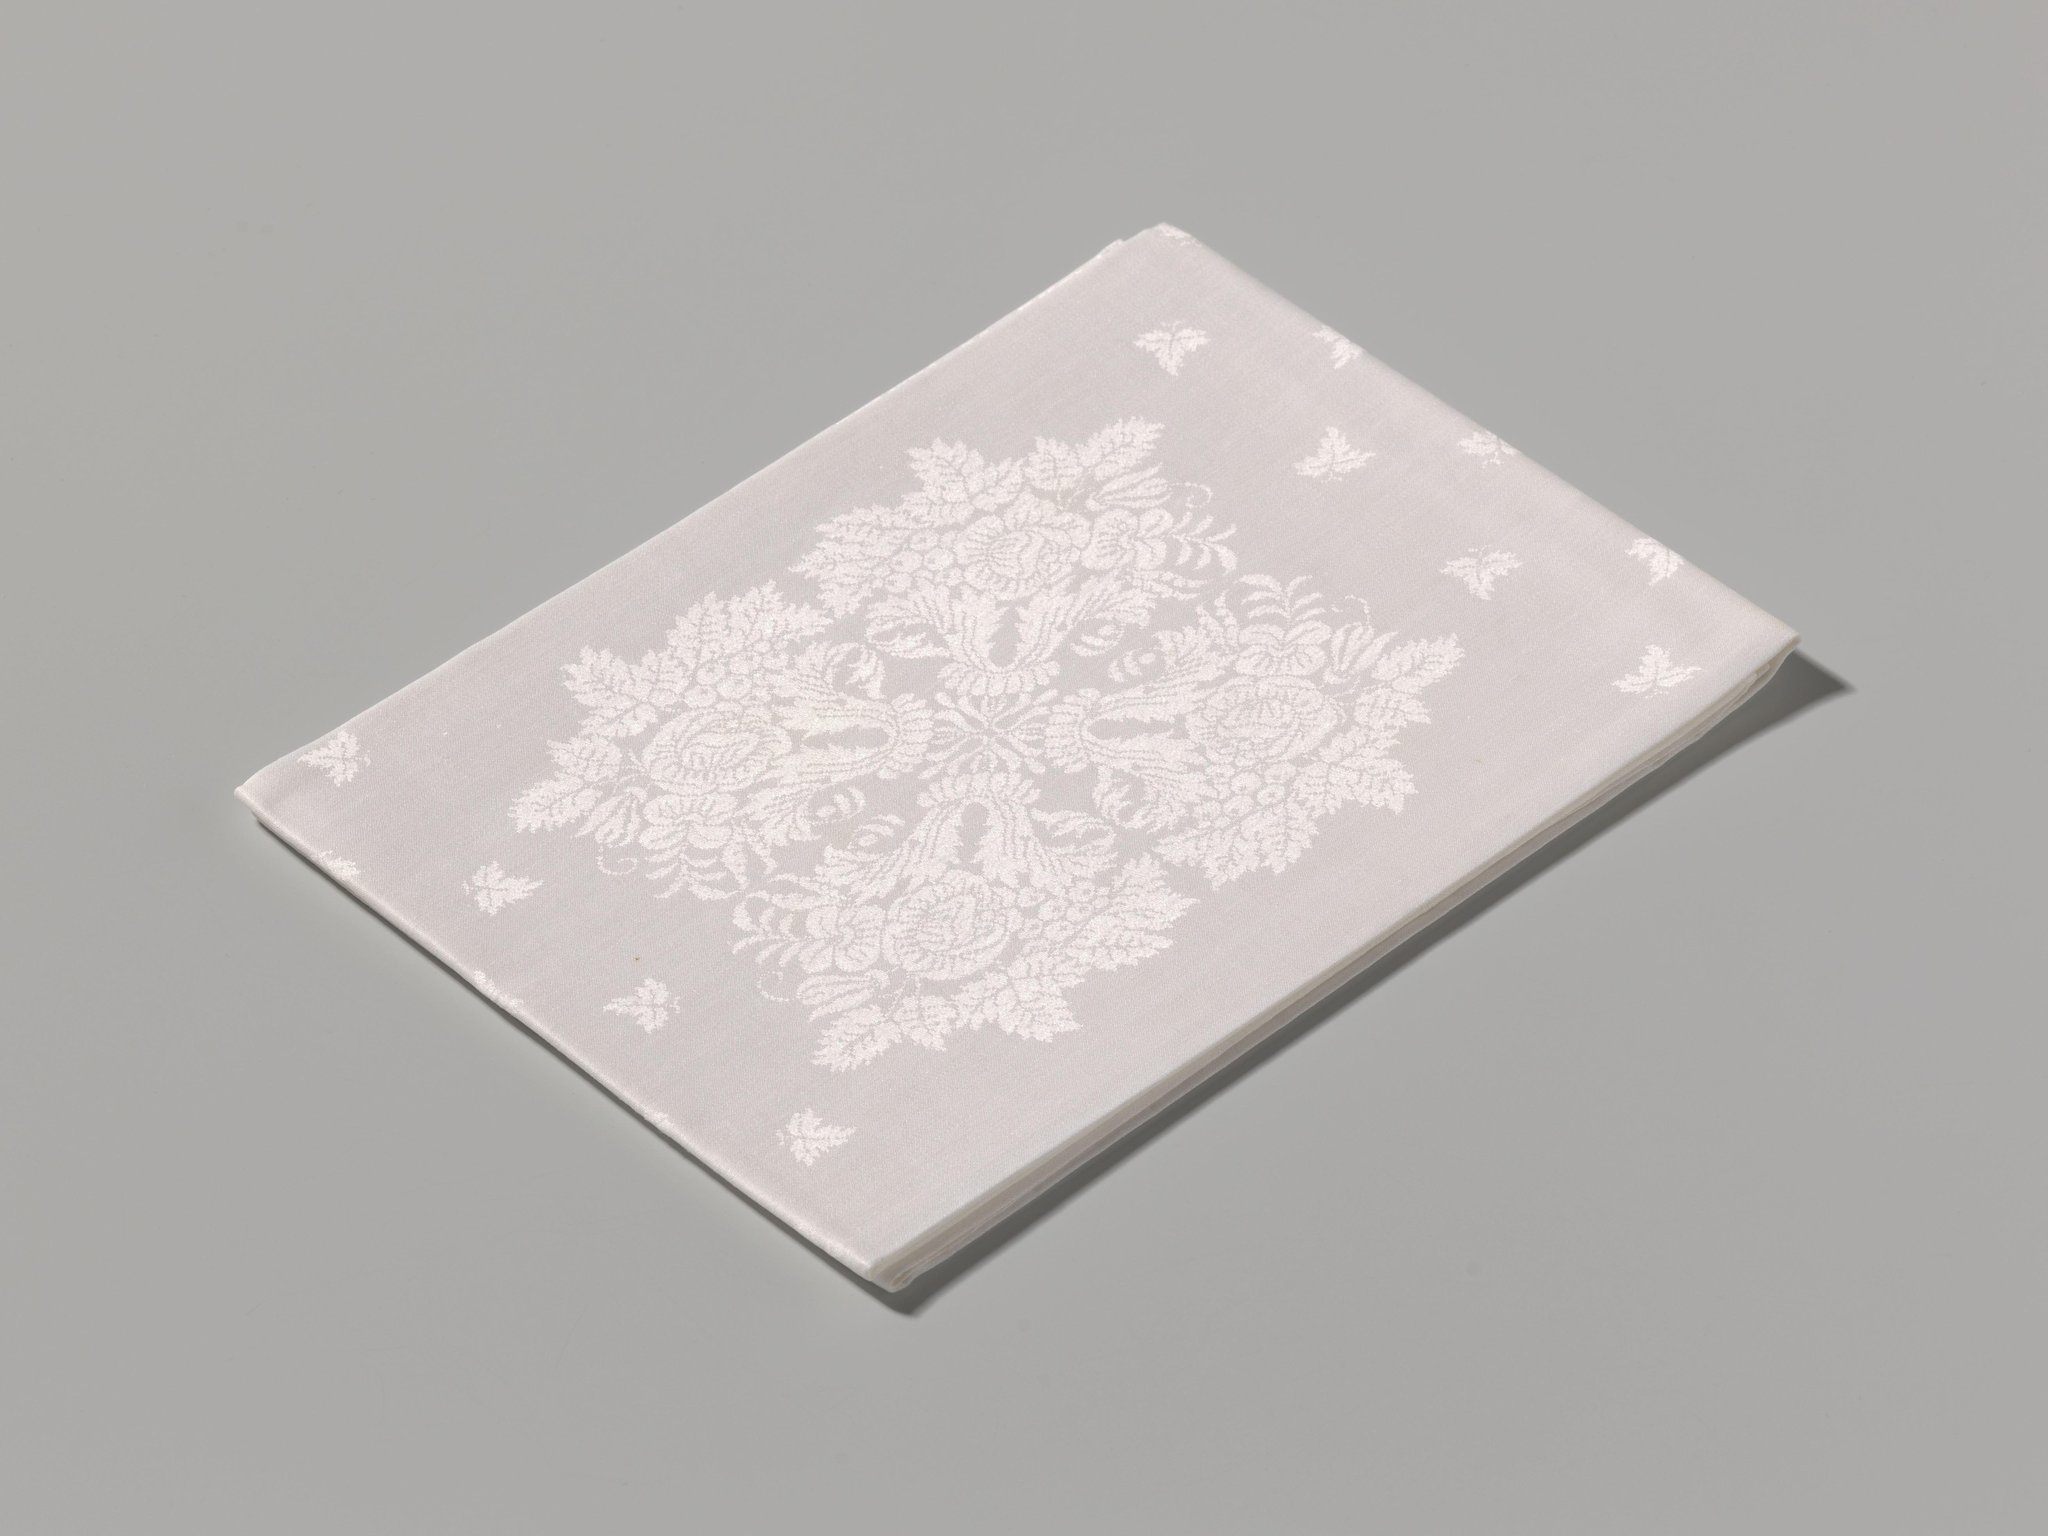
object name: napkin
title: Servet met herme, god en leeuwen te midden van acanthusbladeren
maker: Anonymous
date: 1850-1899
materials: linen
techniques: damask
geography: north brabant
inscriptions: mark: ‘GH 18’, label: ‘R.M. A'dam’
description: Servet van linnendamast met herme, god, leeuwen te midden van acanthusbladeren. Middenveld: Vierpassen van bloemboeketten met roos en gestrooid bladwerk. In de niet omgrensde vierpassen staan de telkens op twee acanthusvoluten geplaatste boeketten overhoeks. Hoeken: overhoeks geplaatst een herme met Midas-kop (of ezelskop?), met muziekinstrumenten en thyrsusstaven. Links en rechts een toegewende leeuw, in toom gehouden door een gevleugelde jonge God (Apollo?) in draperie gehuld. Randen: zonder scheidingslijn is het veld omgeven door een brede rand van symmetrische acanthusranken. Beurtelings dragen de diep ingesneden, gevederde bladvoluten een vruchten- en bloemenmand, of zij staan in twee toegewende spiraalvormen, die in een ramsmasker eindigen, boven twee bloemtakken en een pijnappel.